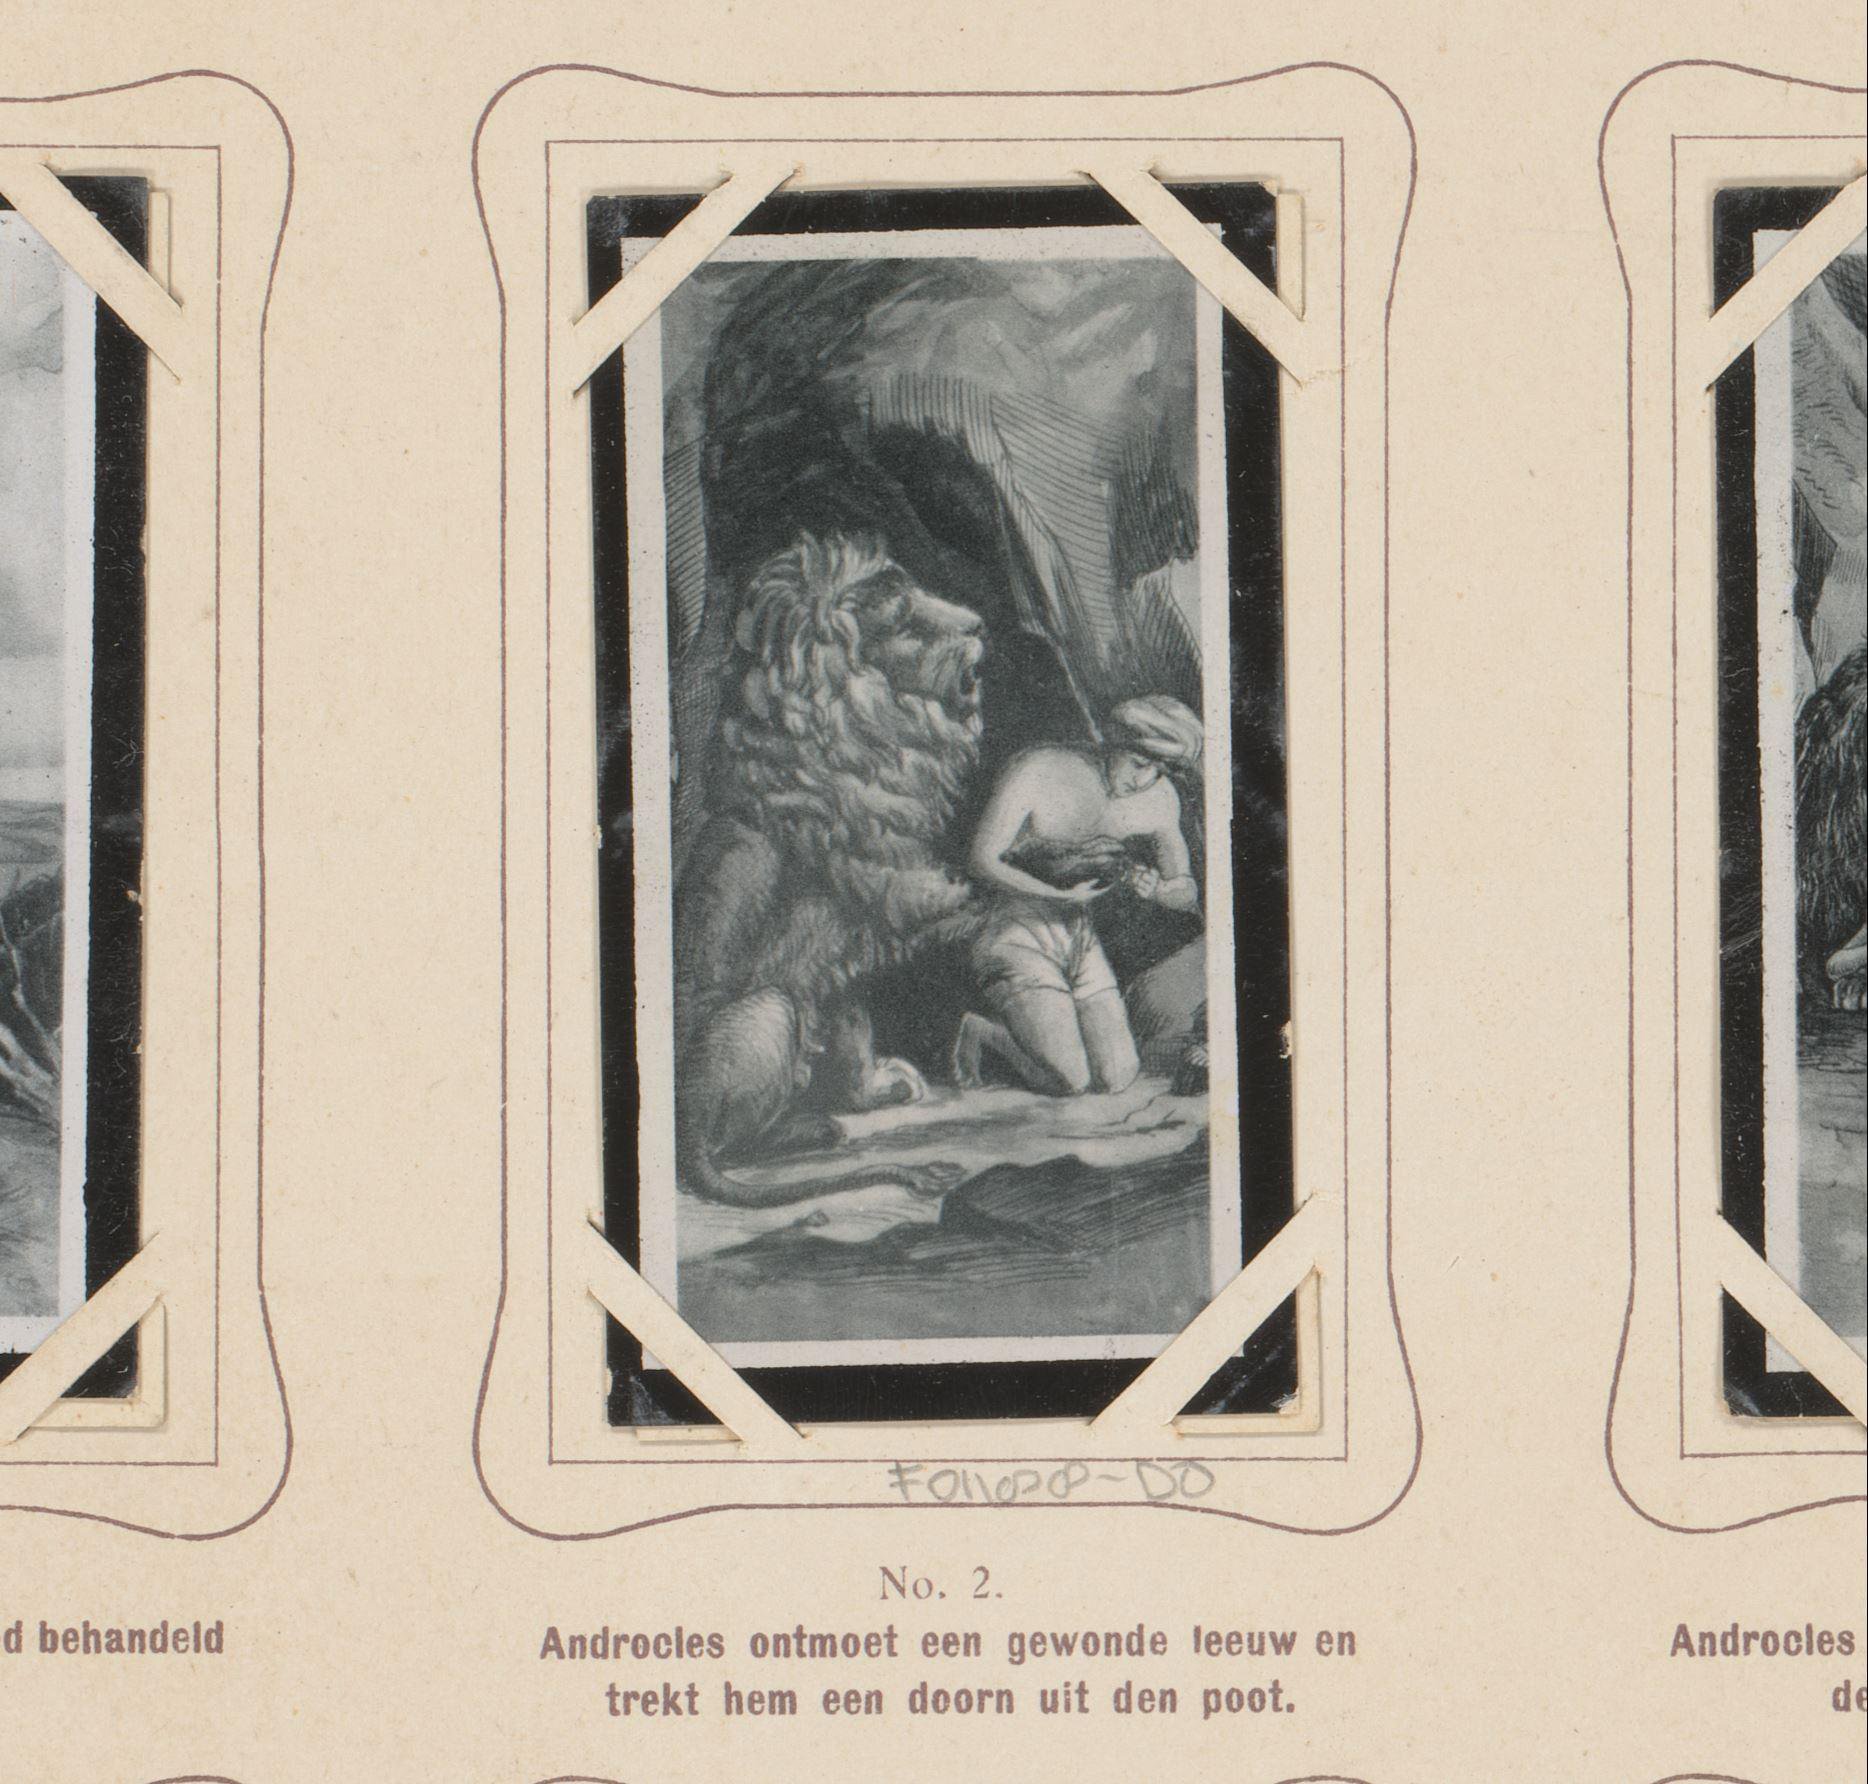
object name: album leaf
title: Reproductie van een tekening met Androclus die de doorn uit de poot van de leeuw haalt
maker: Anonymous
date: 1906-1907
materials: paper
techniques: photograph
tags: (story of) androclus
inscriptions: inscription: ‘No. 2./ Androcles ontmoet een gewonde leeuw en trekt hem een doorn uit den poot.’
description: Deze prent maakt deel uit van een album.